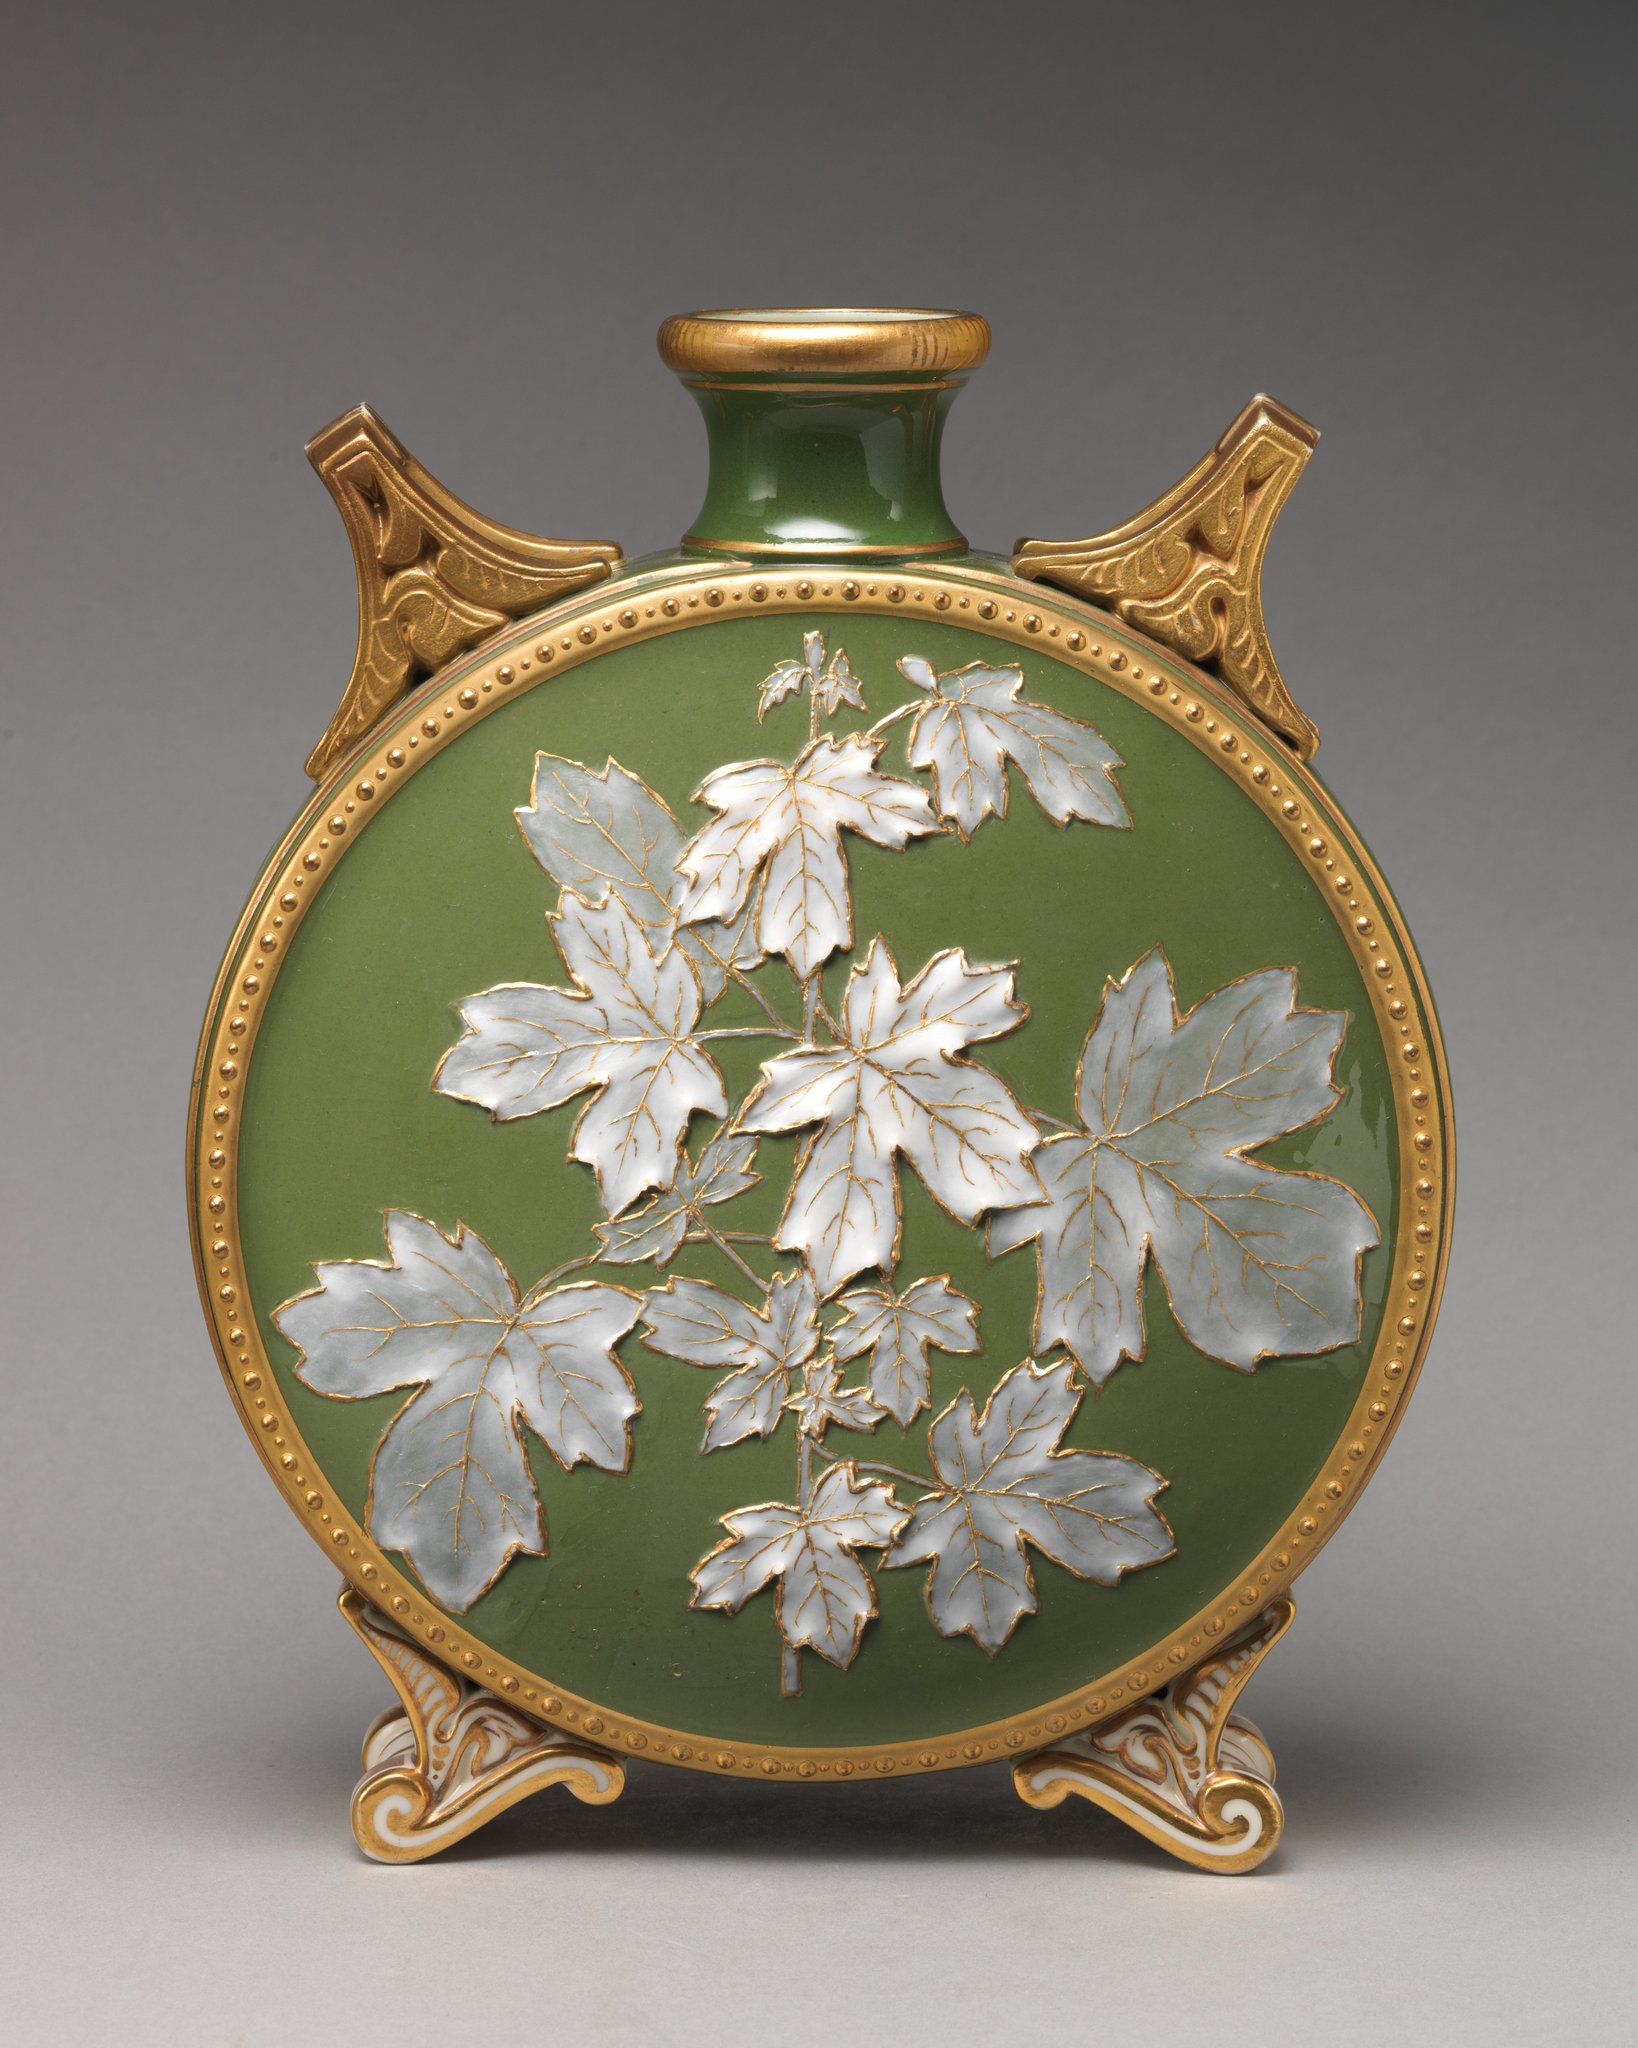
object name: moon flask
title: Moon flask with white grape leaf motifs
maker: grainger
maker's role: maker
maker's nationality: british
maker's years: 1750-1850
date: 1880-1889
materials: porcelain